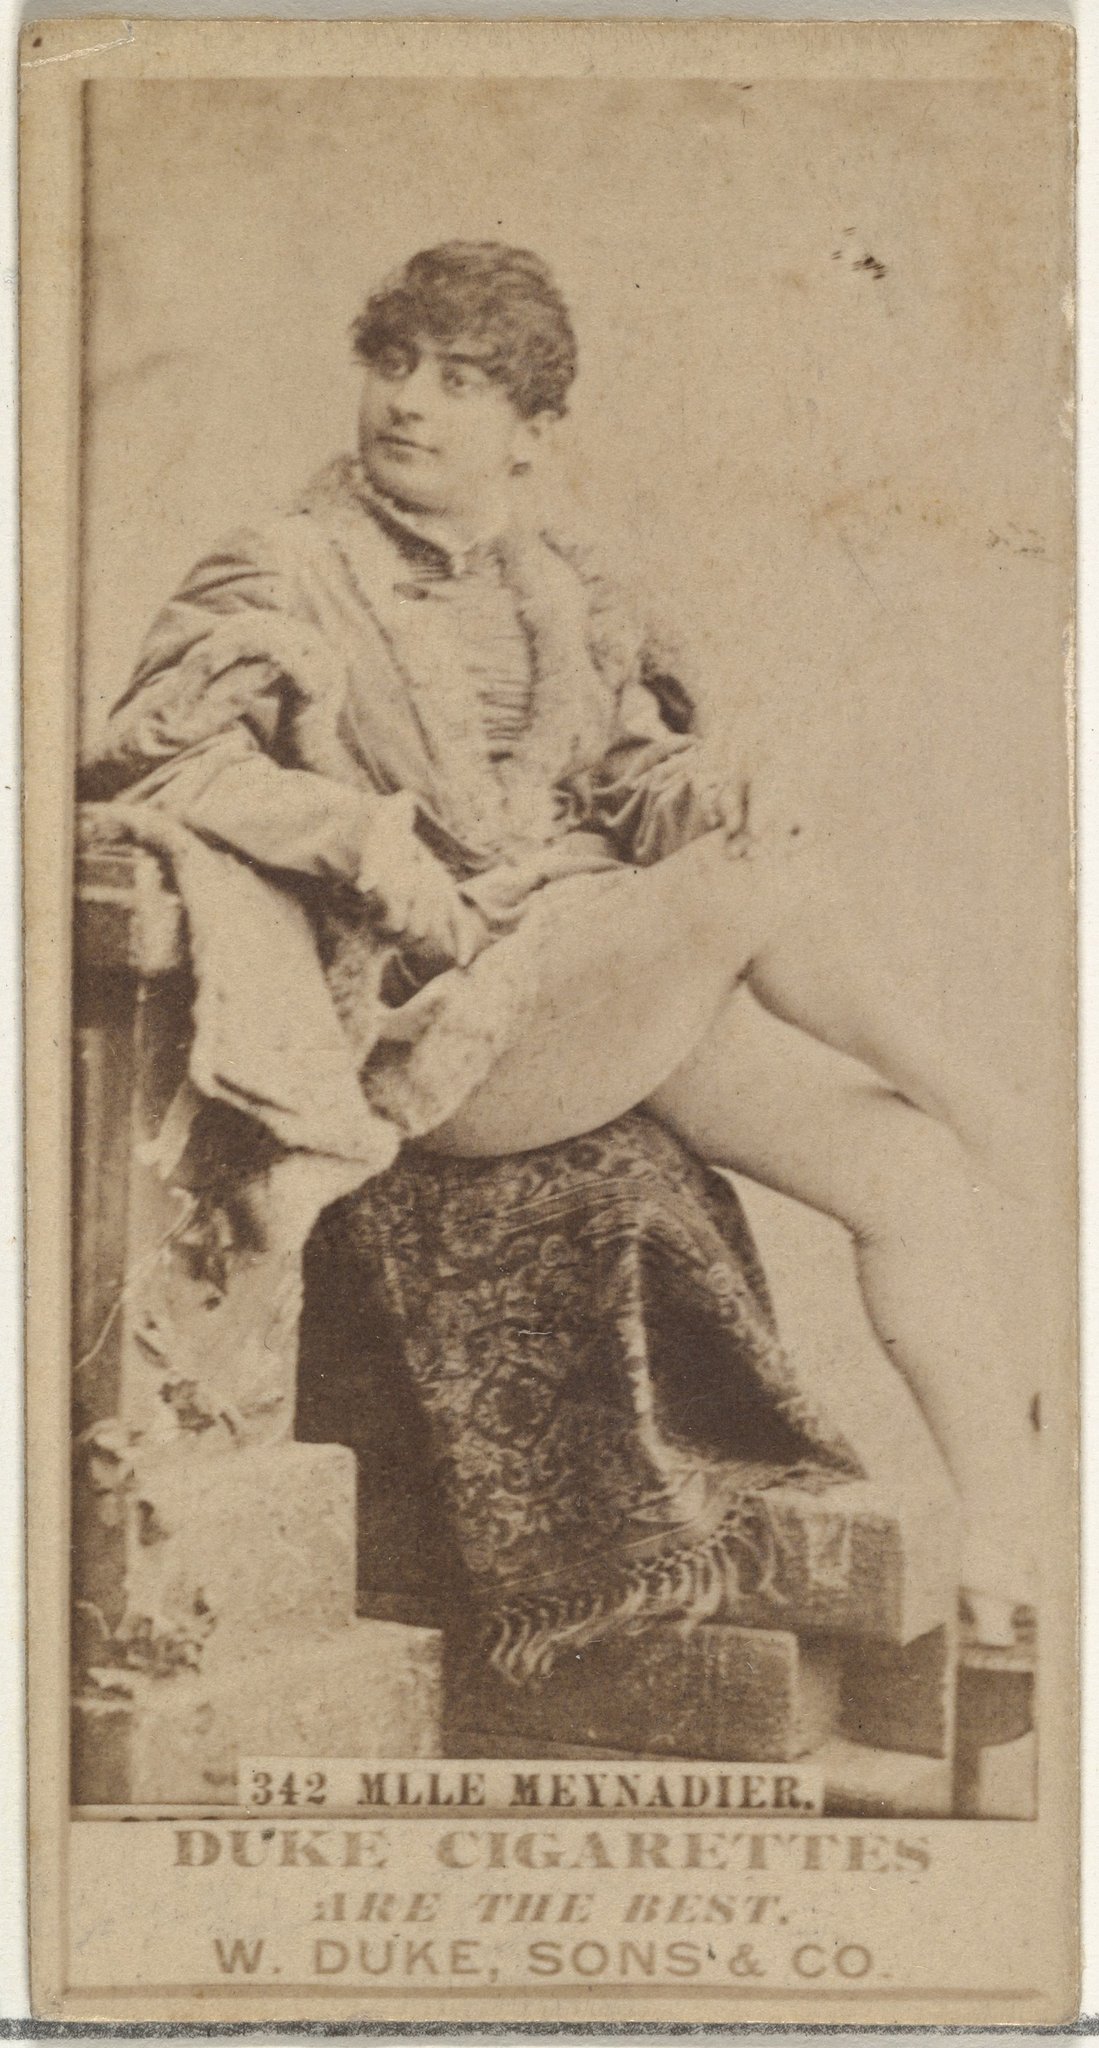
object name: photograph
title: Card Number 342, Mlle. Meynadier, from the Actors and Actresses series (N145-7) issued by Duke Sons & Co. to promote Duke Cigarettes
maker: w. duke, sons & co.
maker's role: publisher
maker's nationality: american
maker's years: 1870-1920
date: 1880-1889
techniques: albumen silver print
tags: portraits,women,actresses